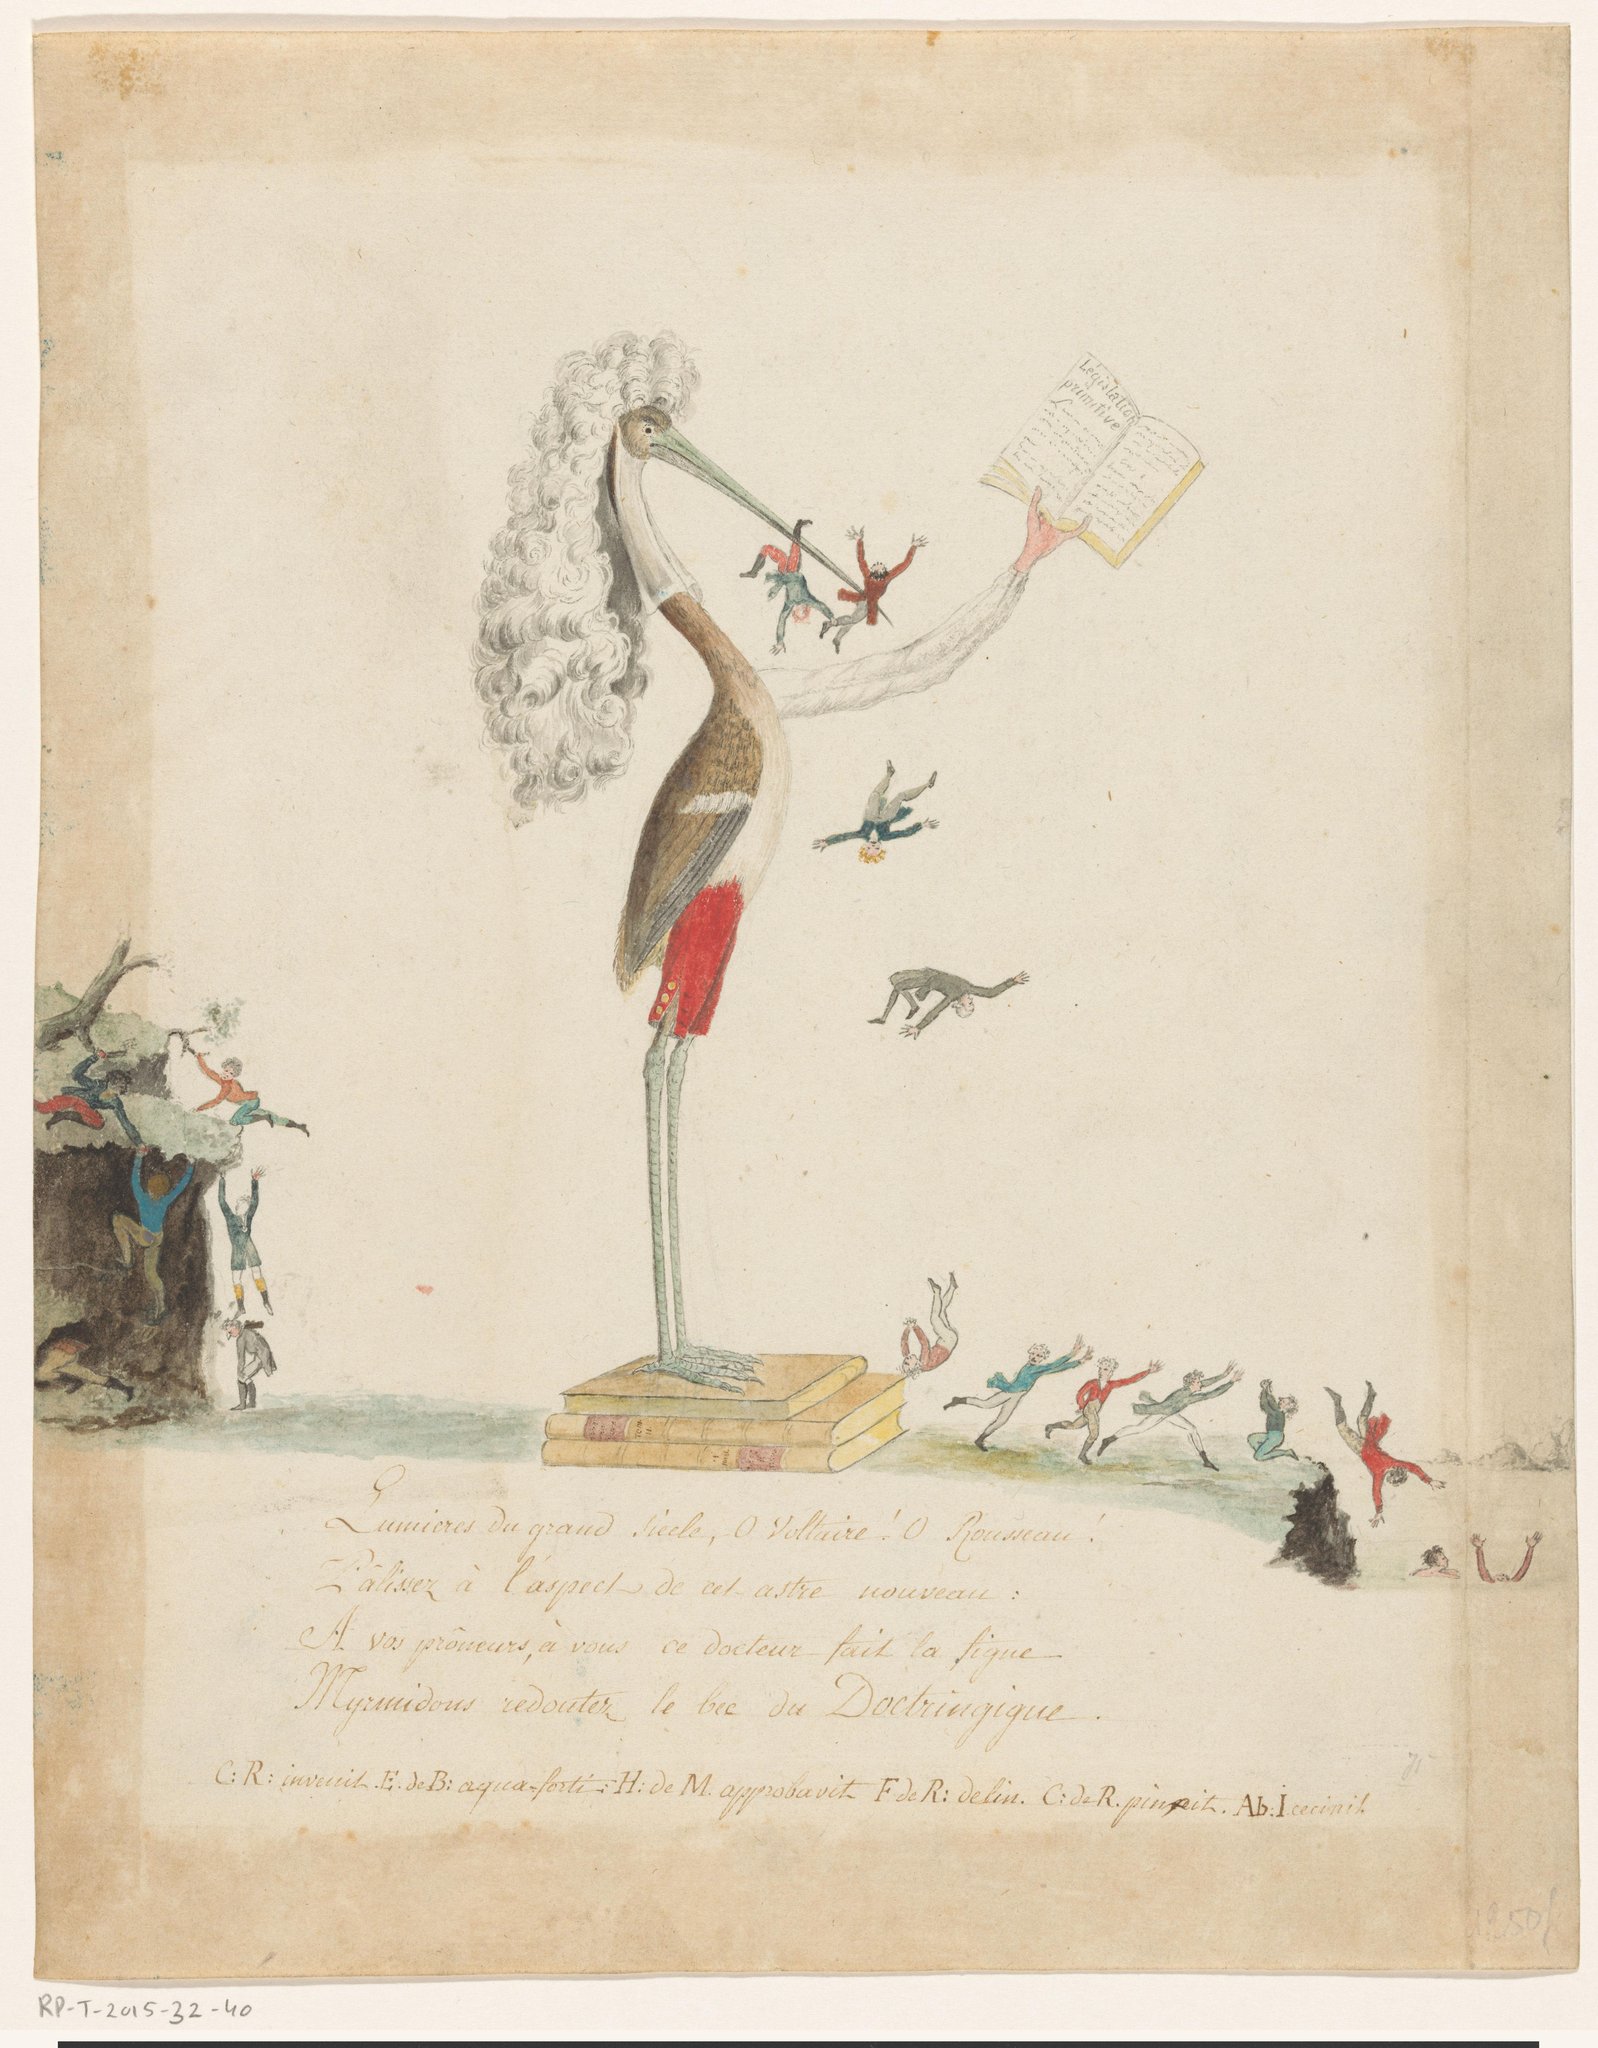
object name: drawing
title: Karikatuur van een jurist in de vorm van een vogel met bef en pruik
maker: Anonymous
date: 1802-1825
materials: ink, paint, paper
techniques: brush, pen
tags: birds, book, state; law; political life, political caricatures and satires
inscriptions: annotation: ‘Lumieres du grand siècle, O Voltaire! O Rousseau! / Palissez à l'aspect de cet astre nouveau: / A vos prôveurs, à vous ce docteur fait la figue / Myrmidons redoutez le bec du Doctringigue.’, watermark: ‘D & C BLAUW’, annotation: ‘C: R: invenit. E. de B: aquaforti: H: de M. approbavit F de R: delin. C: de R. pinxit. Ab: I cecinit.’, collector's mark: Lugt 2228, collector's mark: Lugt 4779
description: Op drie boeken staat een vogel in een rode broek, een bef en een pruik. In zijn hand houdt hij een opengeslagen boek met de titel 'Législation primitive'. Links en rechts vluchten mensen weg van de vogel door op een rots te klimmen, zich te verstoppen in een spelonk of door in het water te springen. Ook vanuit de bek van de vogel vallen mensen op de grond. Met vierregelig gedicht in het Frans.